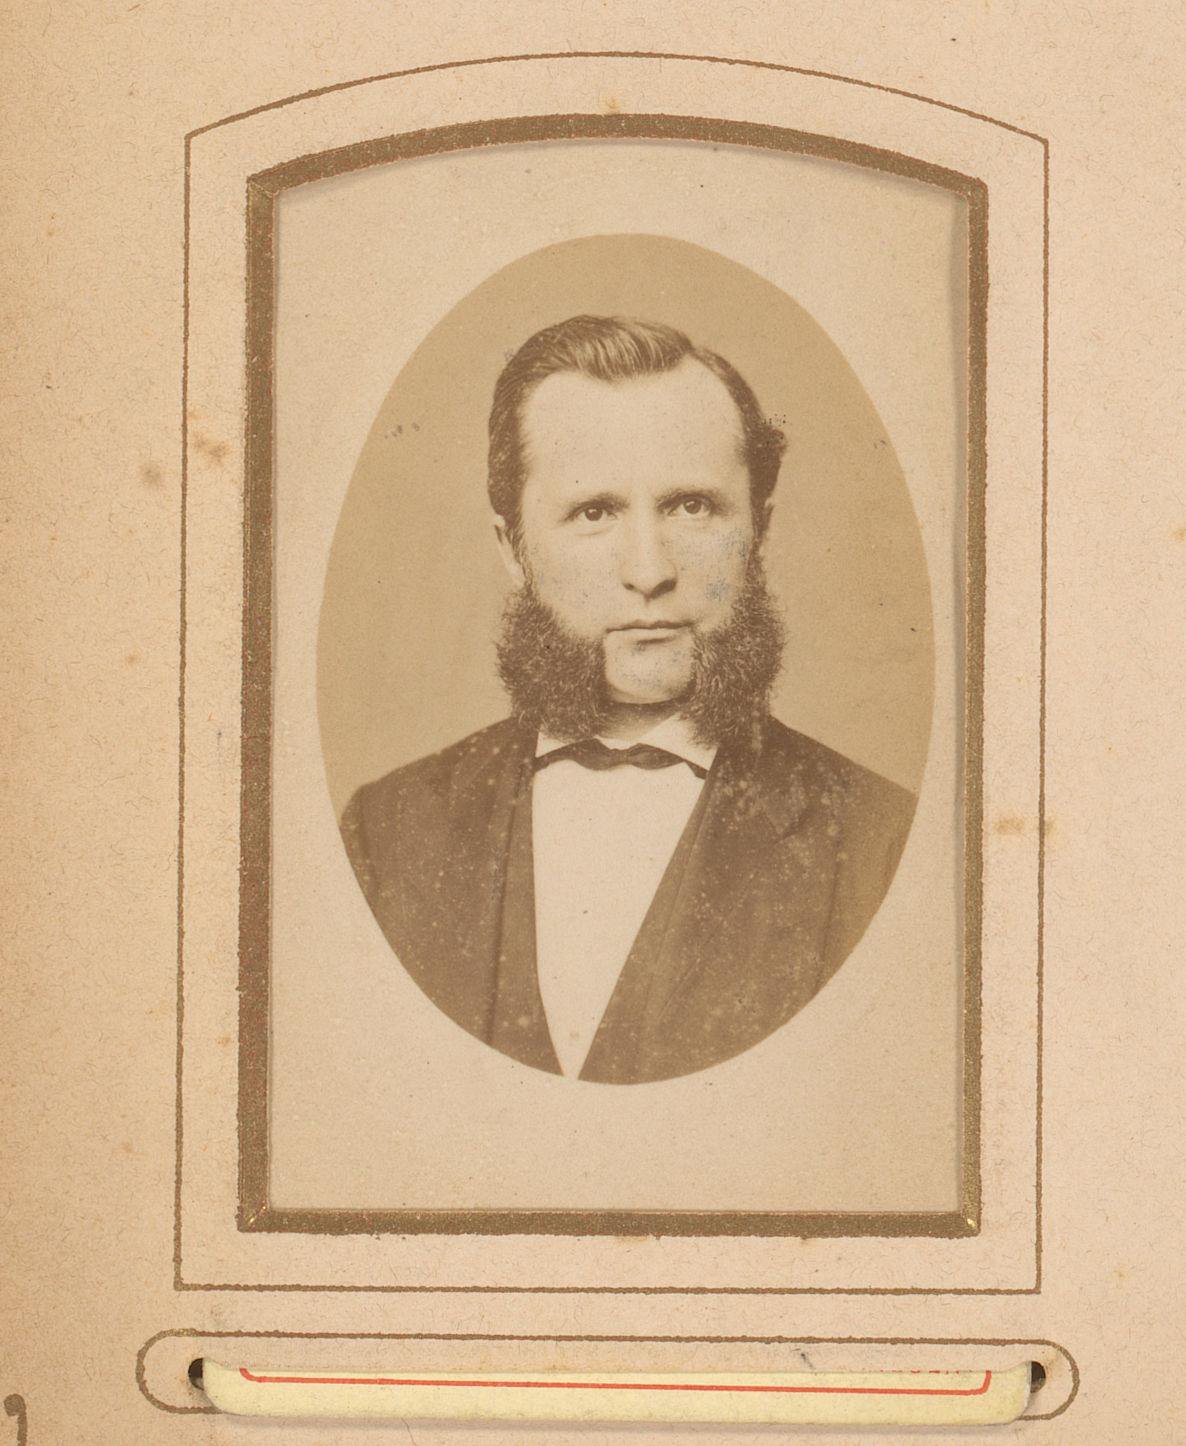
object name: photograph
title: Portret van een man met bakkebaarden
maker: gerard karel martin hubert korfmacher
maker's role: fotograaf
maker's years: 1835-1914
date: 1867-1900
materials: cardboard, photographic support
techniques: albumen print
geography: nijmegen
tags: sideburns, historical persons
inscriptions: inscription: ‘G. Korfmacher phot./ Nijmegen’